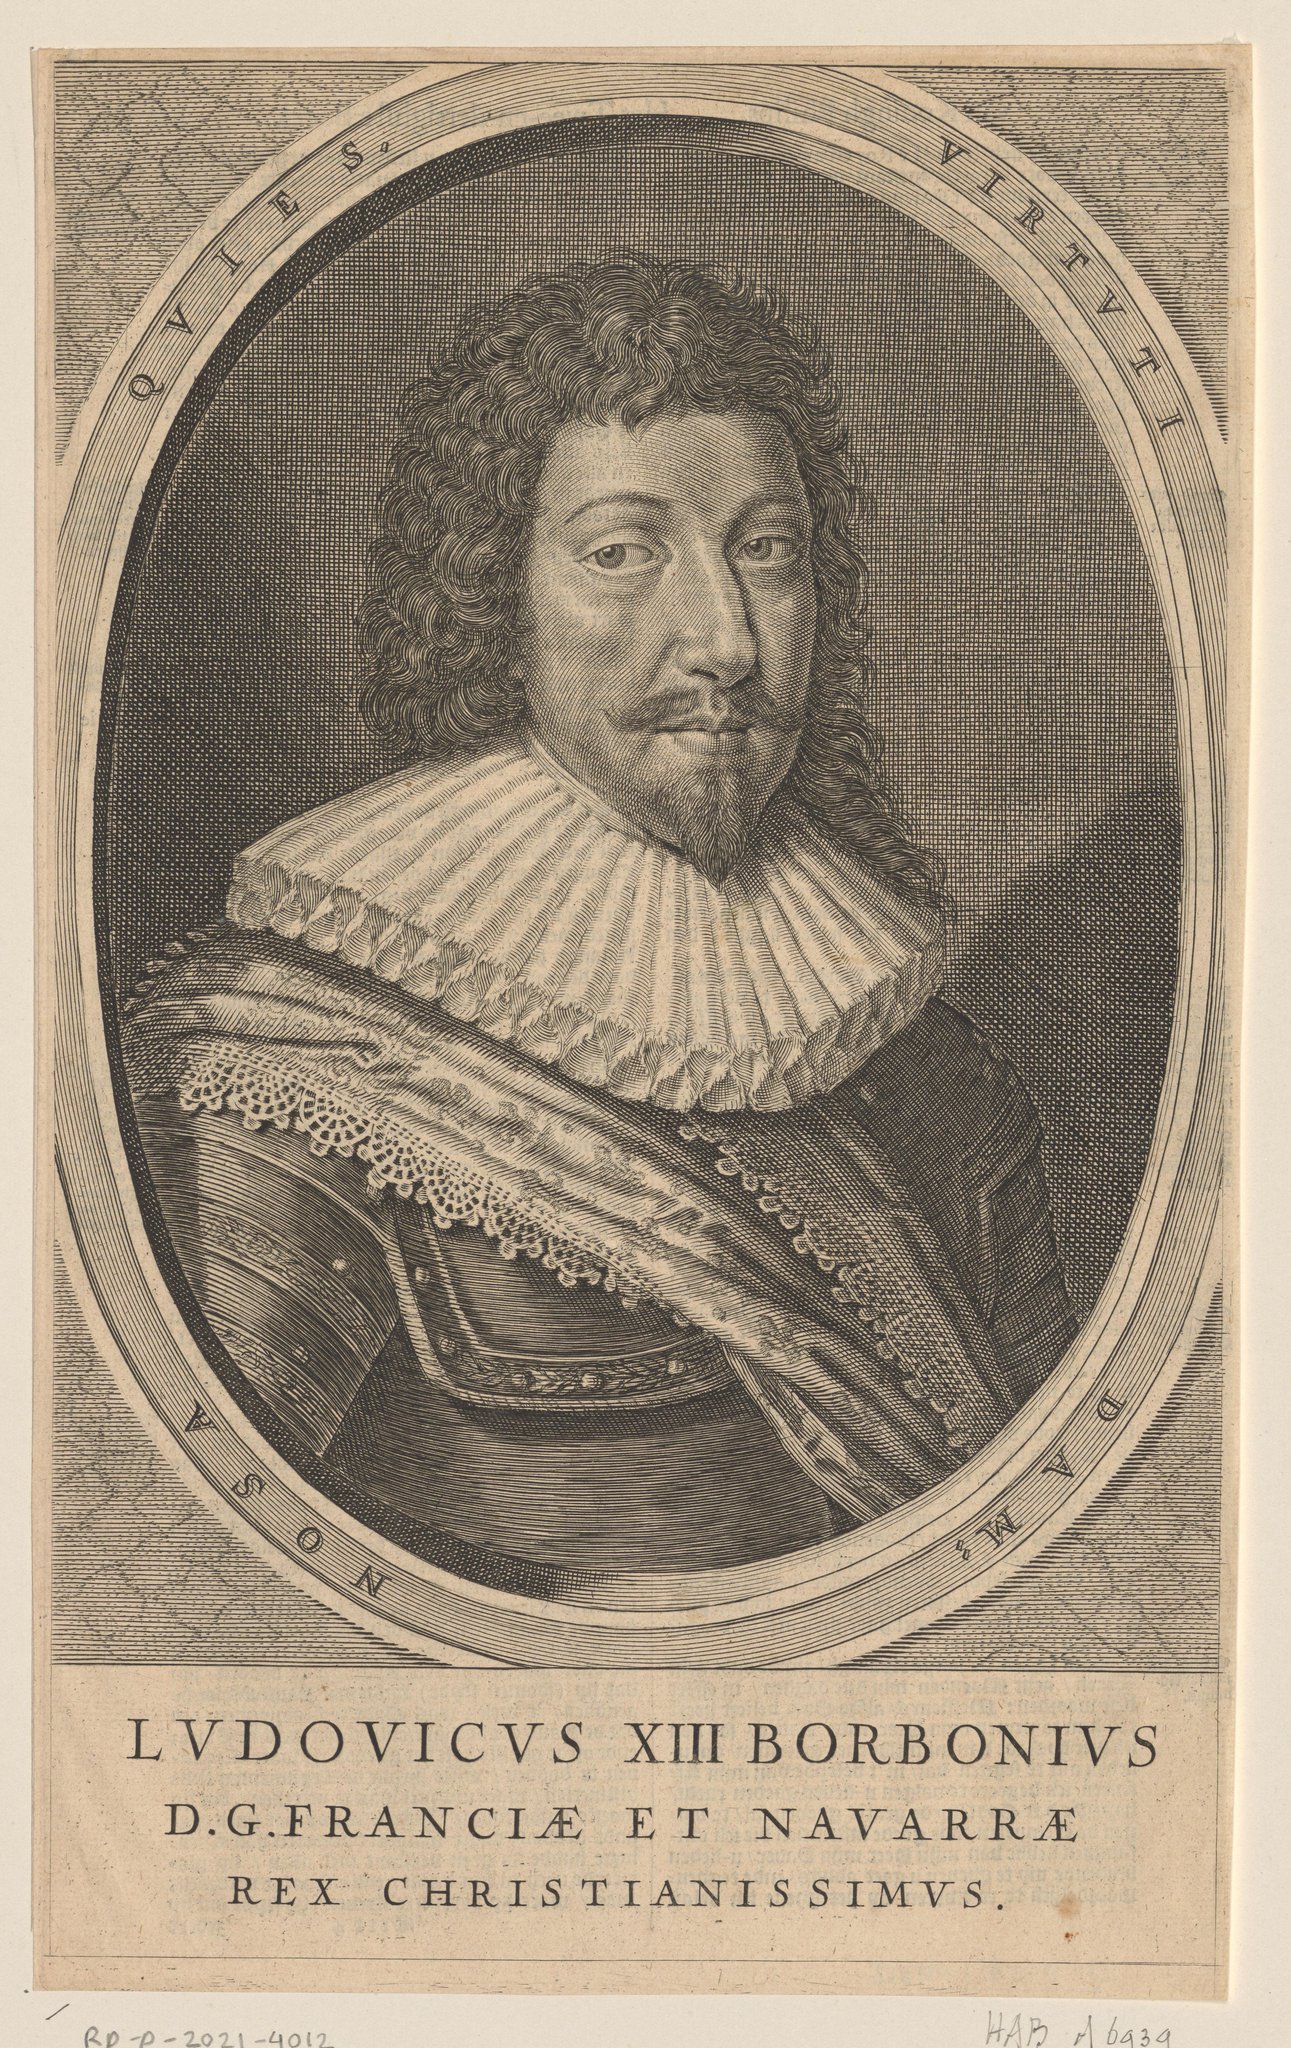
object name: book illustration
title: Portret van Lodewijk XIII van Frankrijk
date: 1652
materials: paper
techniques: engraving, letterpress printing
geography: amsterdam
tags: lodewijk xiii (koning van frankrijk), ornament ~ medallion, armour, historical persons, king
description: Prent uit: Meteren, Emanuel van. Historien der Nederlanden, en haar Naburen Oorlogen tot het Iaar 1612. Amsterdam: Jan Jacobsz. Schipper, 1652, tussen p. 612 en 613.